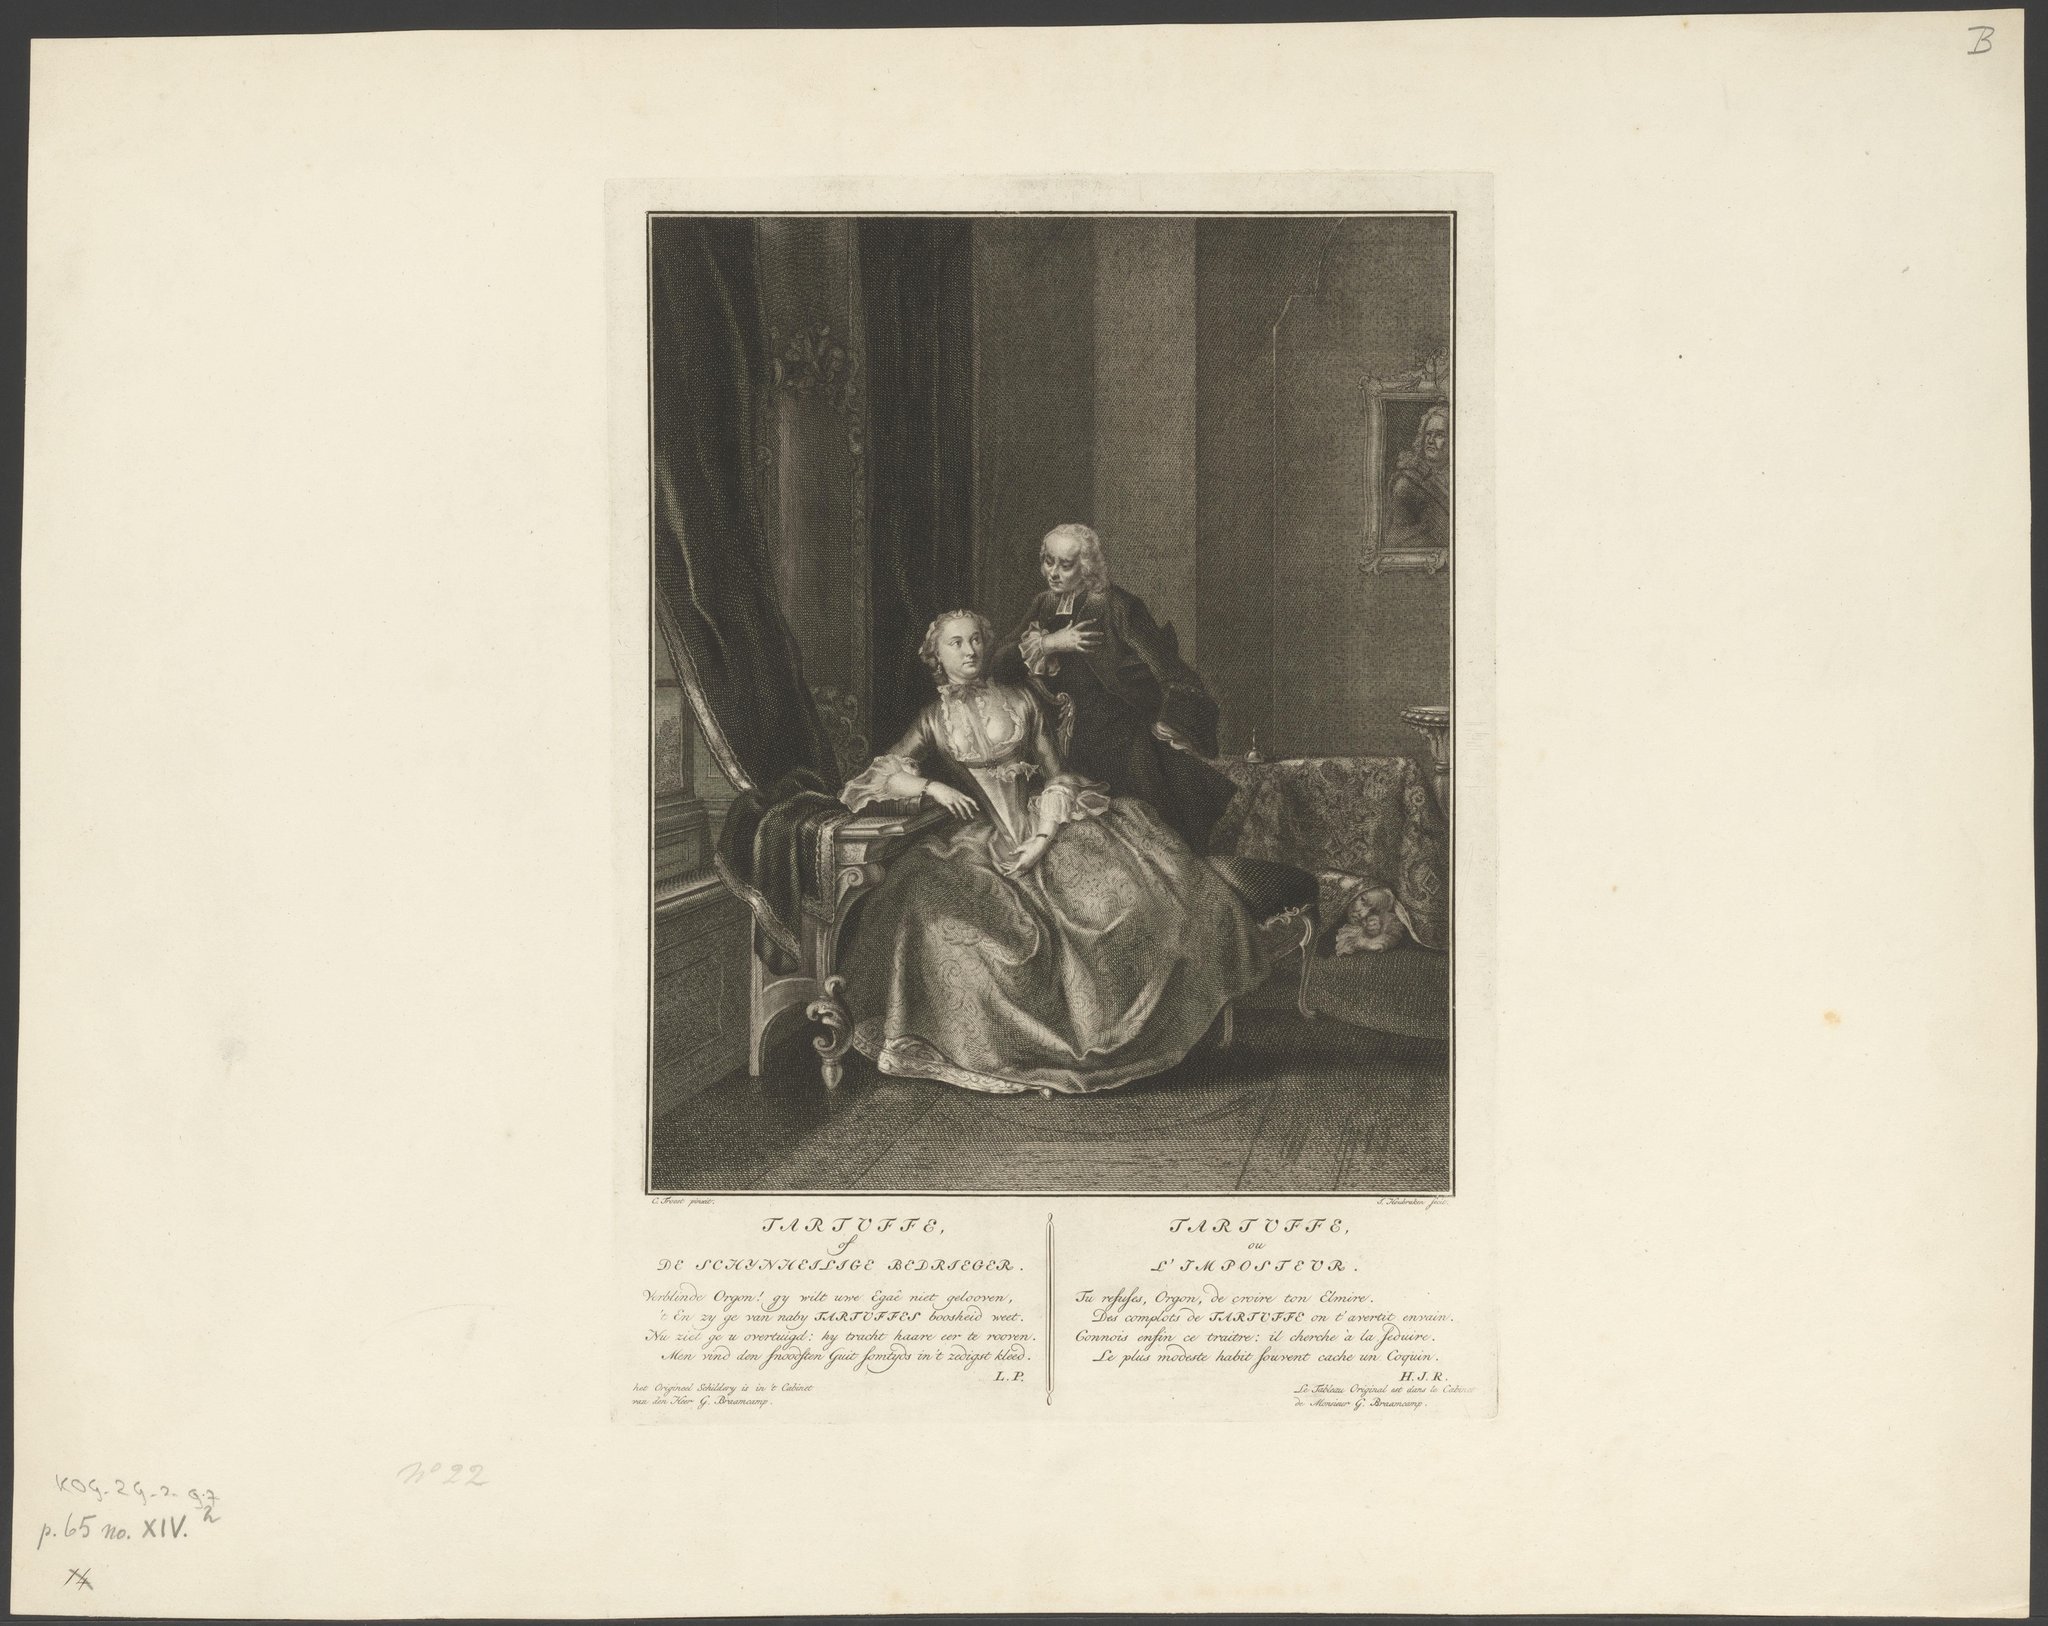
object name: print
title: Tartuffe of de schijnheilige bedrieger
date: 1754-1764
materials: paper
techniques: engraving, etching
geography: amsterdam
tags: male literary characters (with name), unsuccessful love affair; seduction, pursuit of a woman, prowling, eavesdropper, comedy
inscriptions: collector's mark: Lugt 2488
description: Interieur met een dame, Elmire en een heer, Tartuffe. Op de achtergrond ligt onder een tafel een tweede man, Orgon. Scène uit het toneelstuk Tartuffe van Molière uit 1664: de dame, Elmire, gekleed in een japon met diep decolleté zit op een stoel, haar rechterarm leunend op een dik boek op een tafeltje. Achter haar staat het personage Tartuffe, die haar probeert te verleiden. Op de achtergrond is te zien hoe onder een tafel haar echtgenoot Orgon de twee gade slaat. Elmire overtuigt via deze list haar echtgenoot ervan dat zijn blind vertrouwen in Tartuffe, een geloofsfanaticus, wordt misbruikt. Onderaan in de marge twee vierregelige verzen in het Nederlands en Frans.